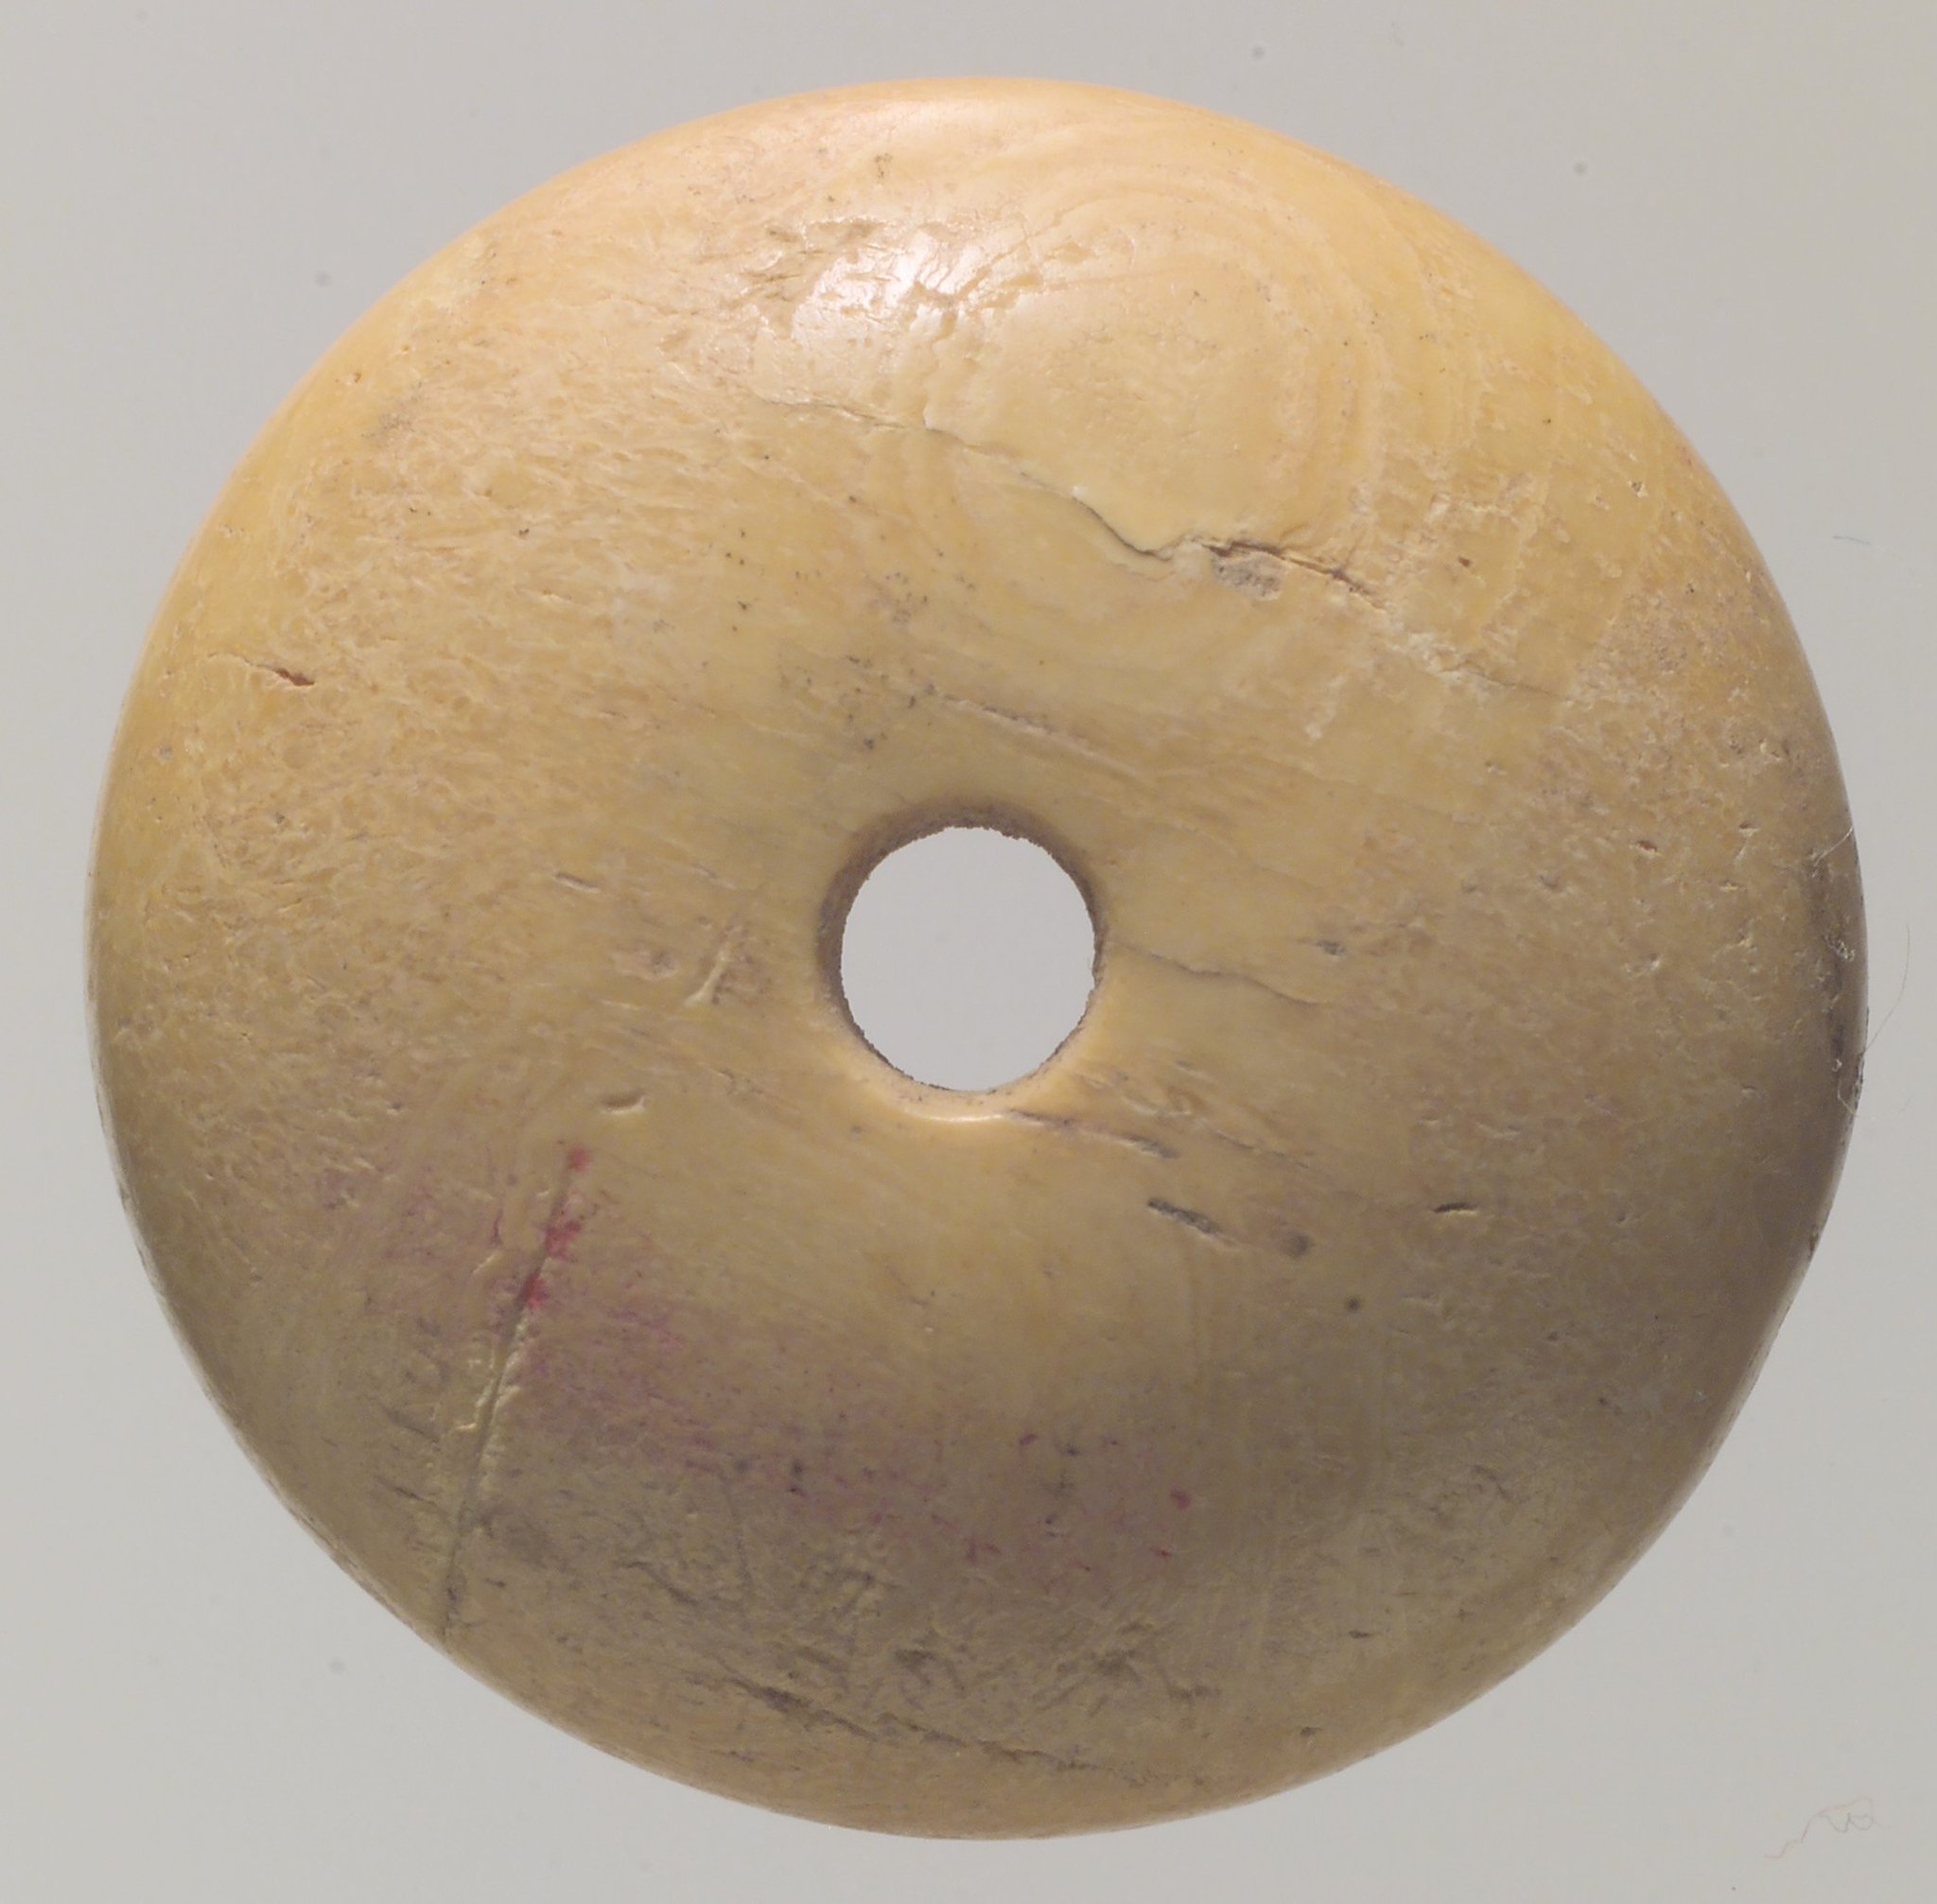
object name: whorl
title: Spindle whorl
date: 3000-1001 BCE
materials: bone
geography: mesopotamia